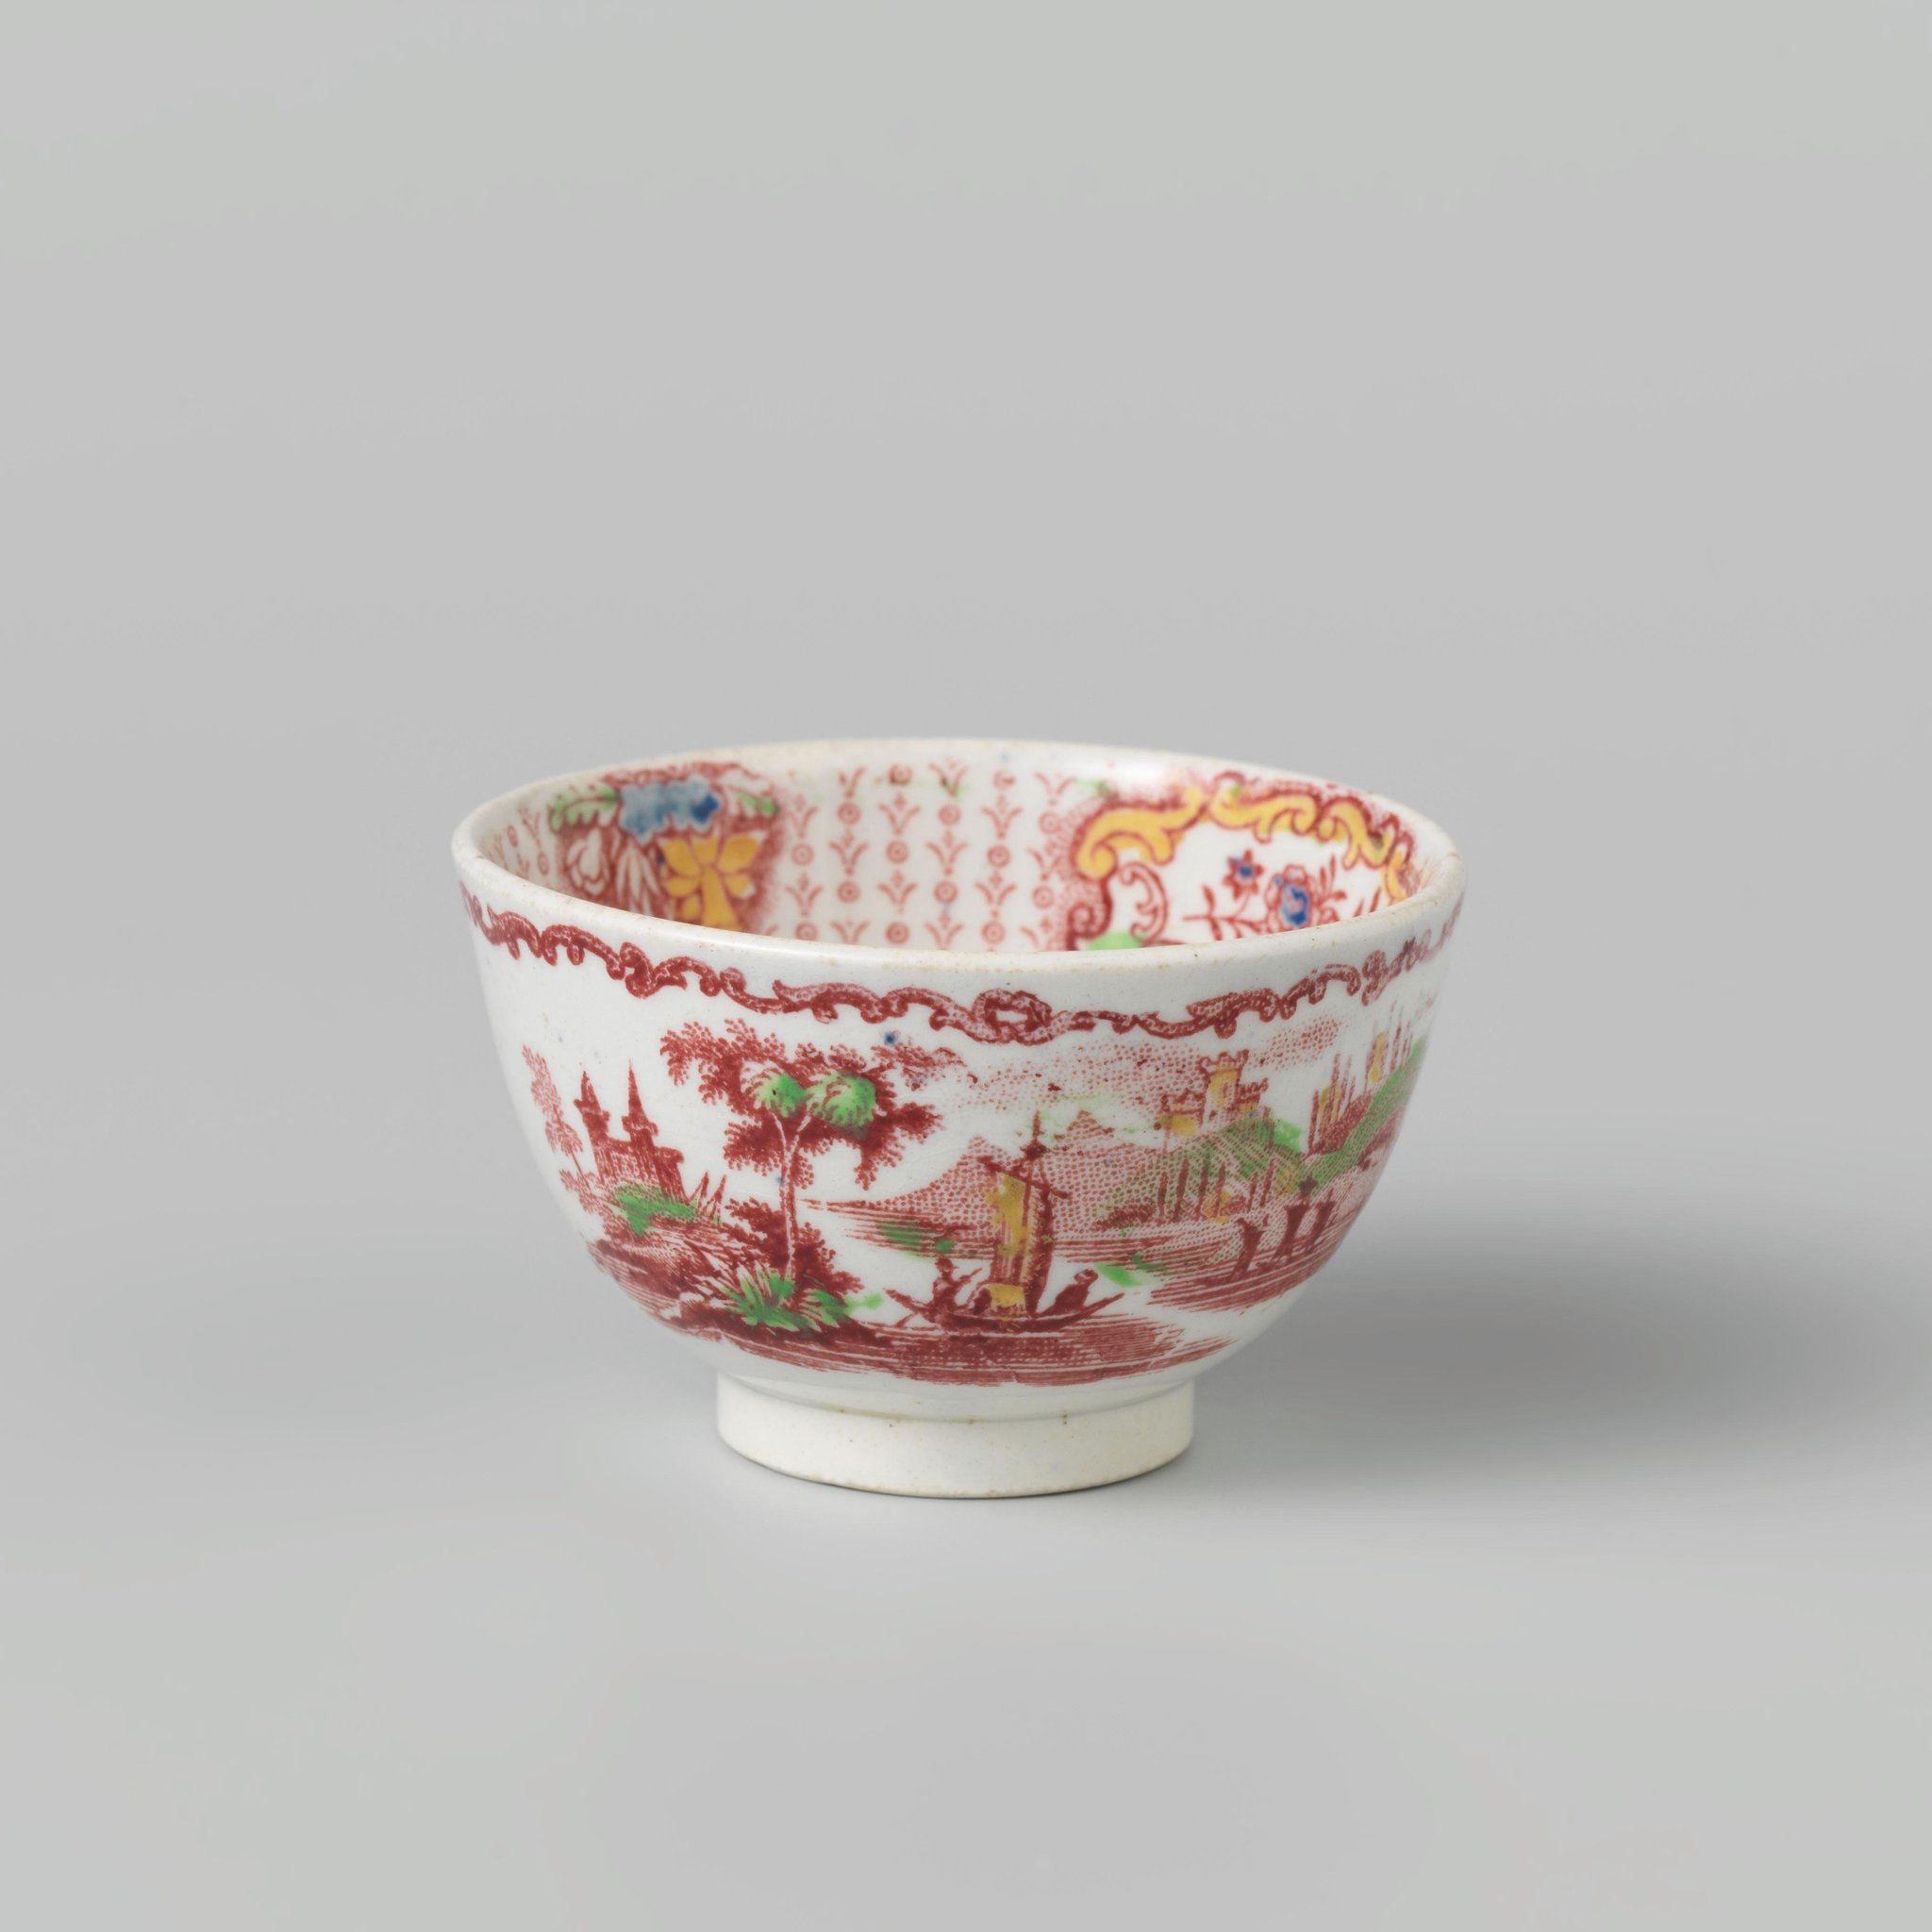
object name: cup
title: Kop van hardgebakken aardewerk, fijn creamware met transfer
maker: Anonymous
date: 1830-1850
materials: earthenware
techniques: transfer decoration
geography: england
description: Halfbolvormige kop van hardgebakken aardewerk met veelkleurige transfer. De buitenwand heeft een afbeelding van twee rivierlandschappen, de binnenwand heeft twee medaillons waarin bloemtakken en twee boeketten tussen een fond van gestileerde verticale takken. De kop hoort bij een schotel en bij drie gelijke koppen met schotels (BK-14818-A-1 t/m BK-14818-D-2).